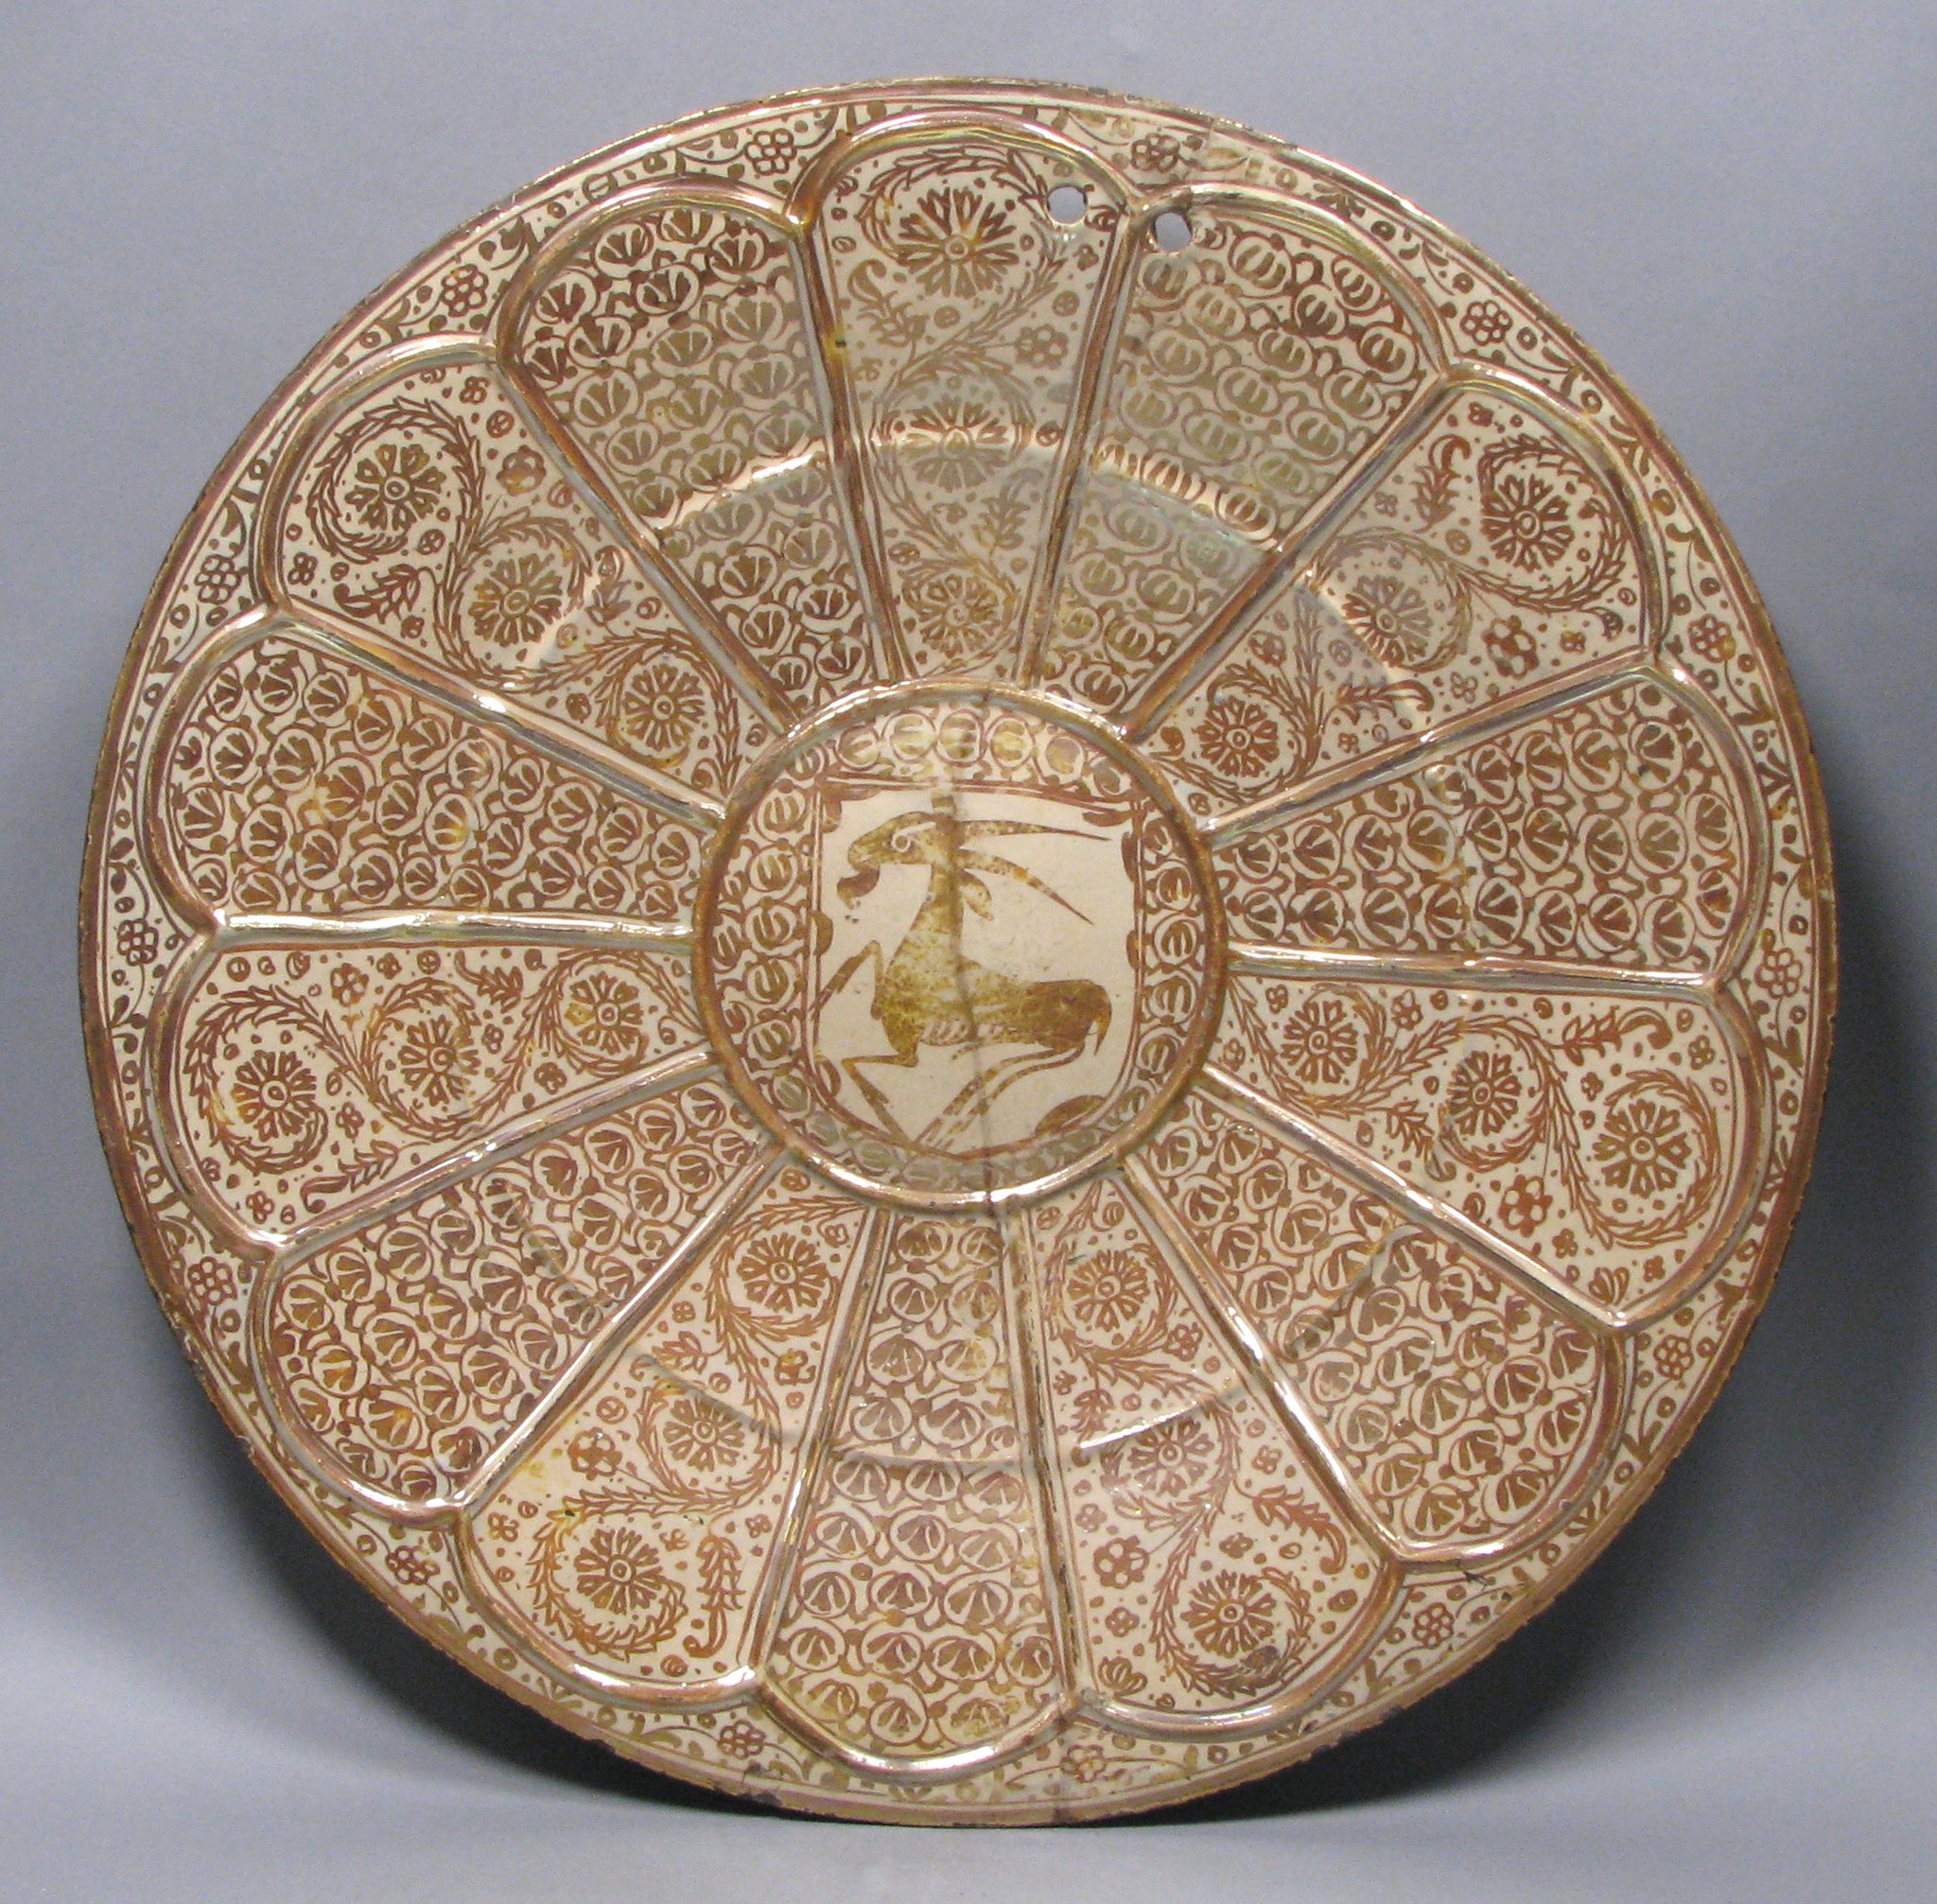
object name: dish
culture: spanish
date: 1401-1433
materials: earthenware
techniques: glazing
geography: spain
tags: coat of arms